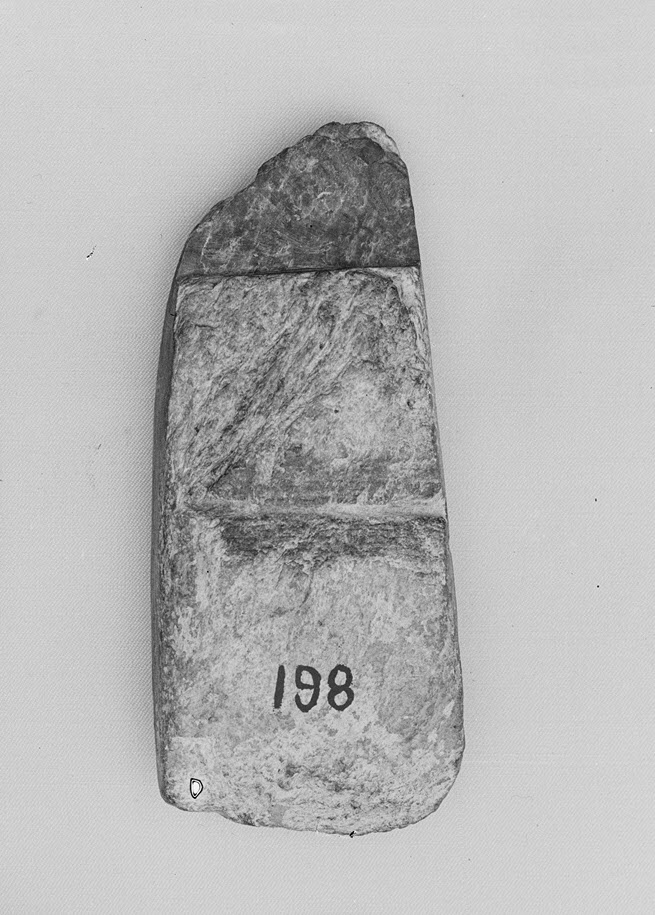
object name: hatchet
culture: swiss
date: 1902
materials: jade